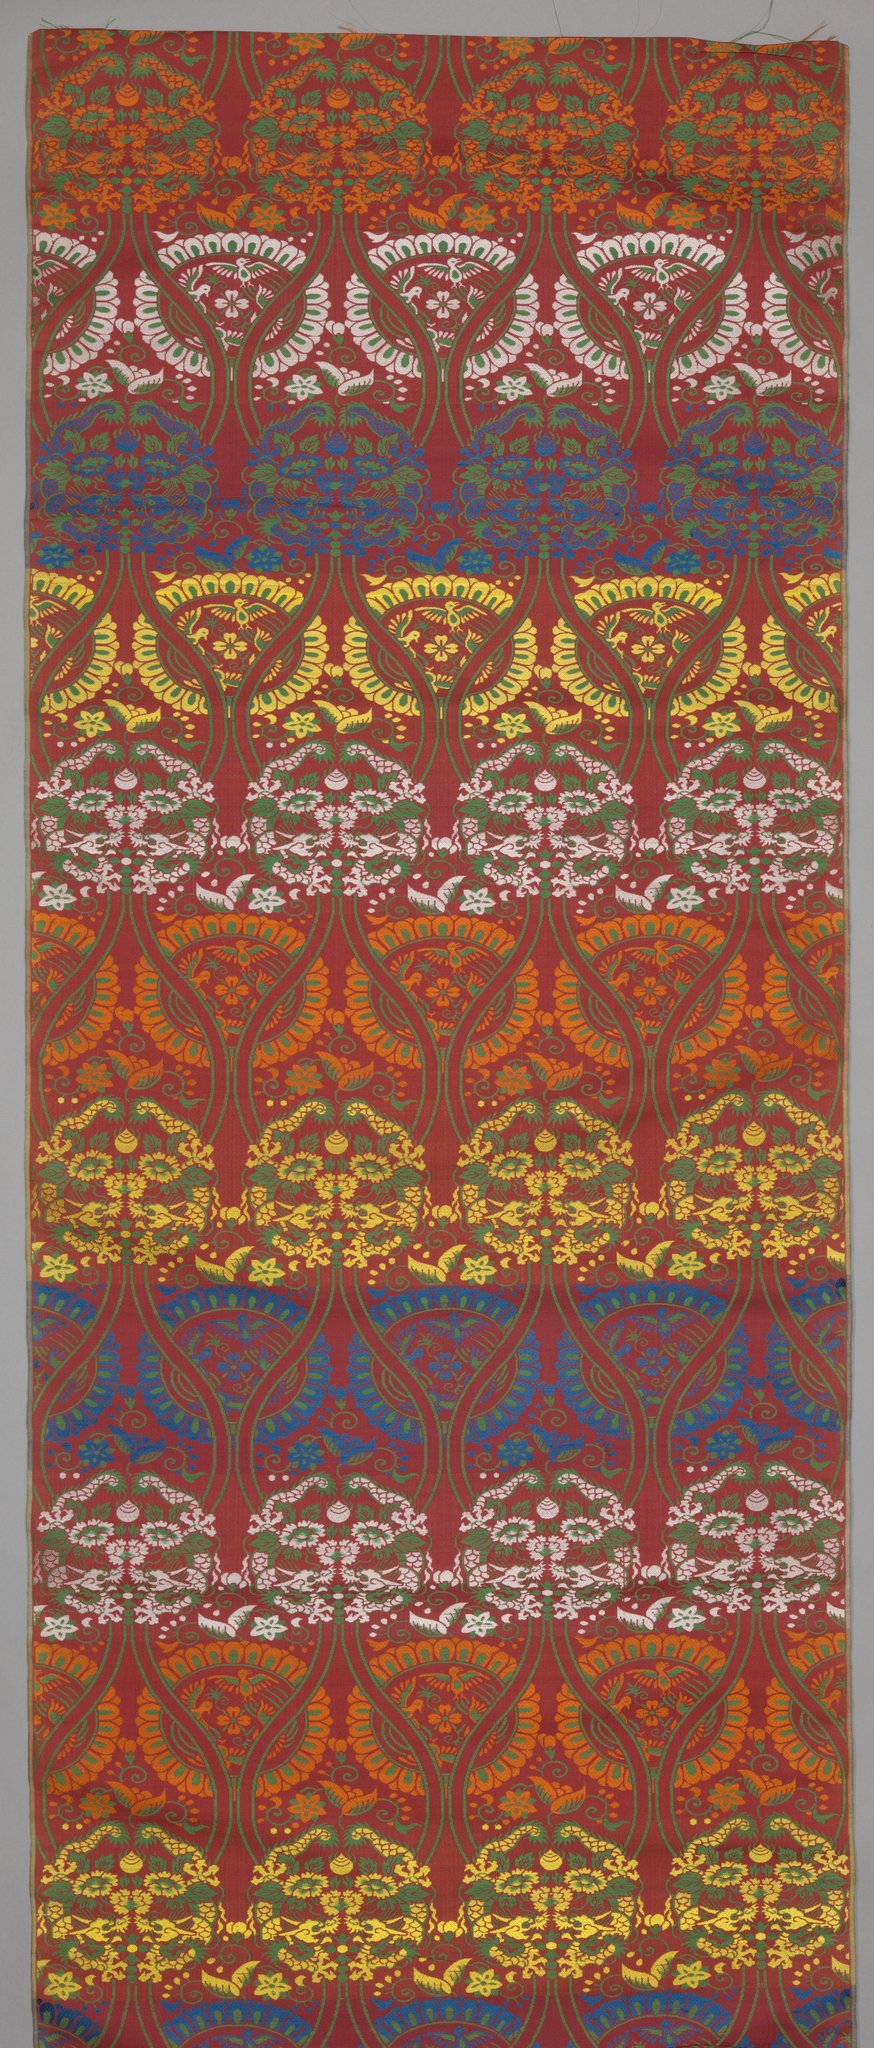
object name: textile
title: Baan zijde met dessin van pseudo-spitsovalen onderbroken door horizontale banden van ovalen met bloembladeren en gevuld door vogels en bloemen en bijna-cirkels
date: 1900-1920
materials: silk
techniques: weave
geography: japan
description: Baan zijde met dessin van pseudo-spitsovalen in groen, onderbroken door horizontale banden van respectievelijk ovalen gevormd door bloembladeren, het ovaal gevuld door vogels en bloemen, en bijna-cirkels opgebouwd door draden en bloemen, respectievelijk in wit en groen, blauw en groen, geel en groen, wit en groen, oranje en groen, geel en groen, blauw en groen en wit en groen op een rood fond. Oosterse textiel.